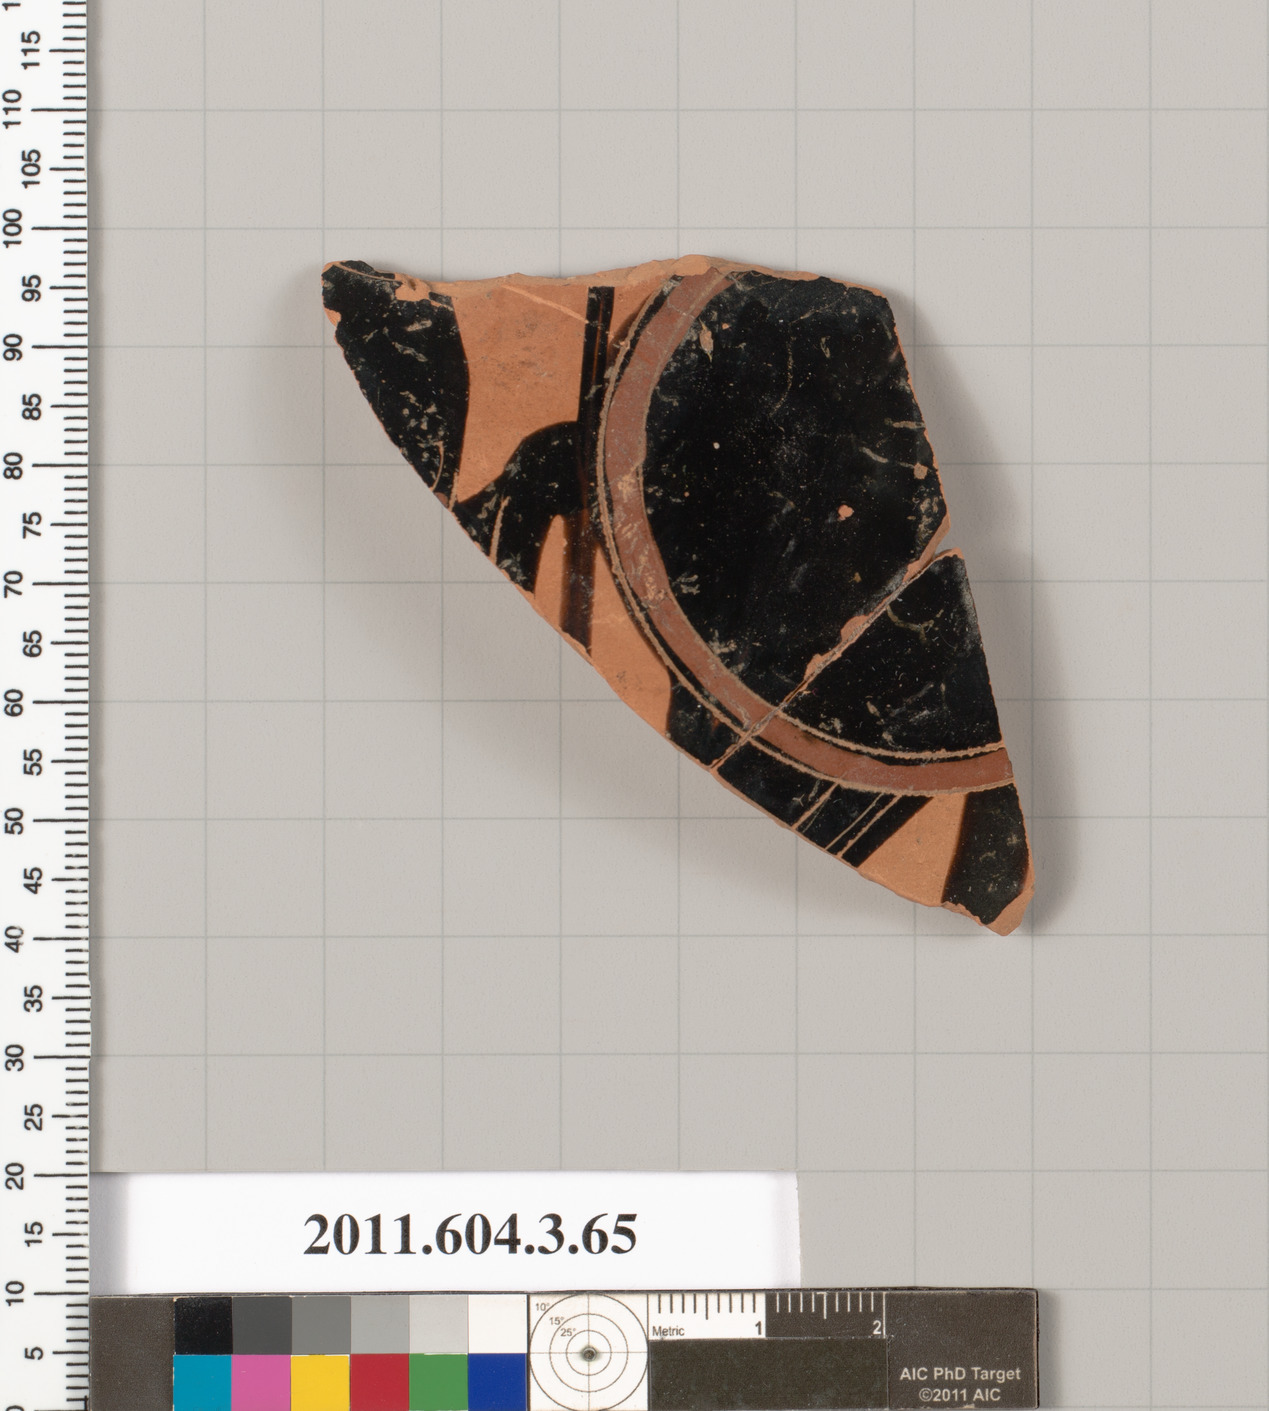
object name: amphora fragment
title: Terracotta fragment of an amphora (jar)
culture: greek, attic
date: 500-468 BCE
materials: terracotta